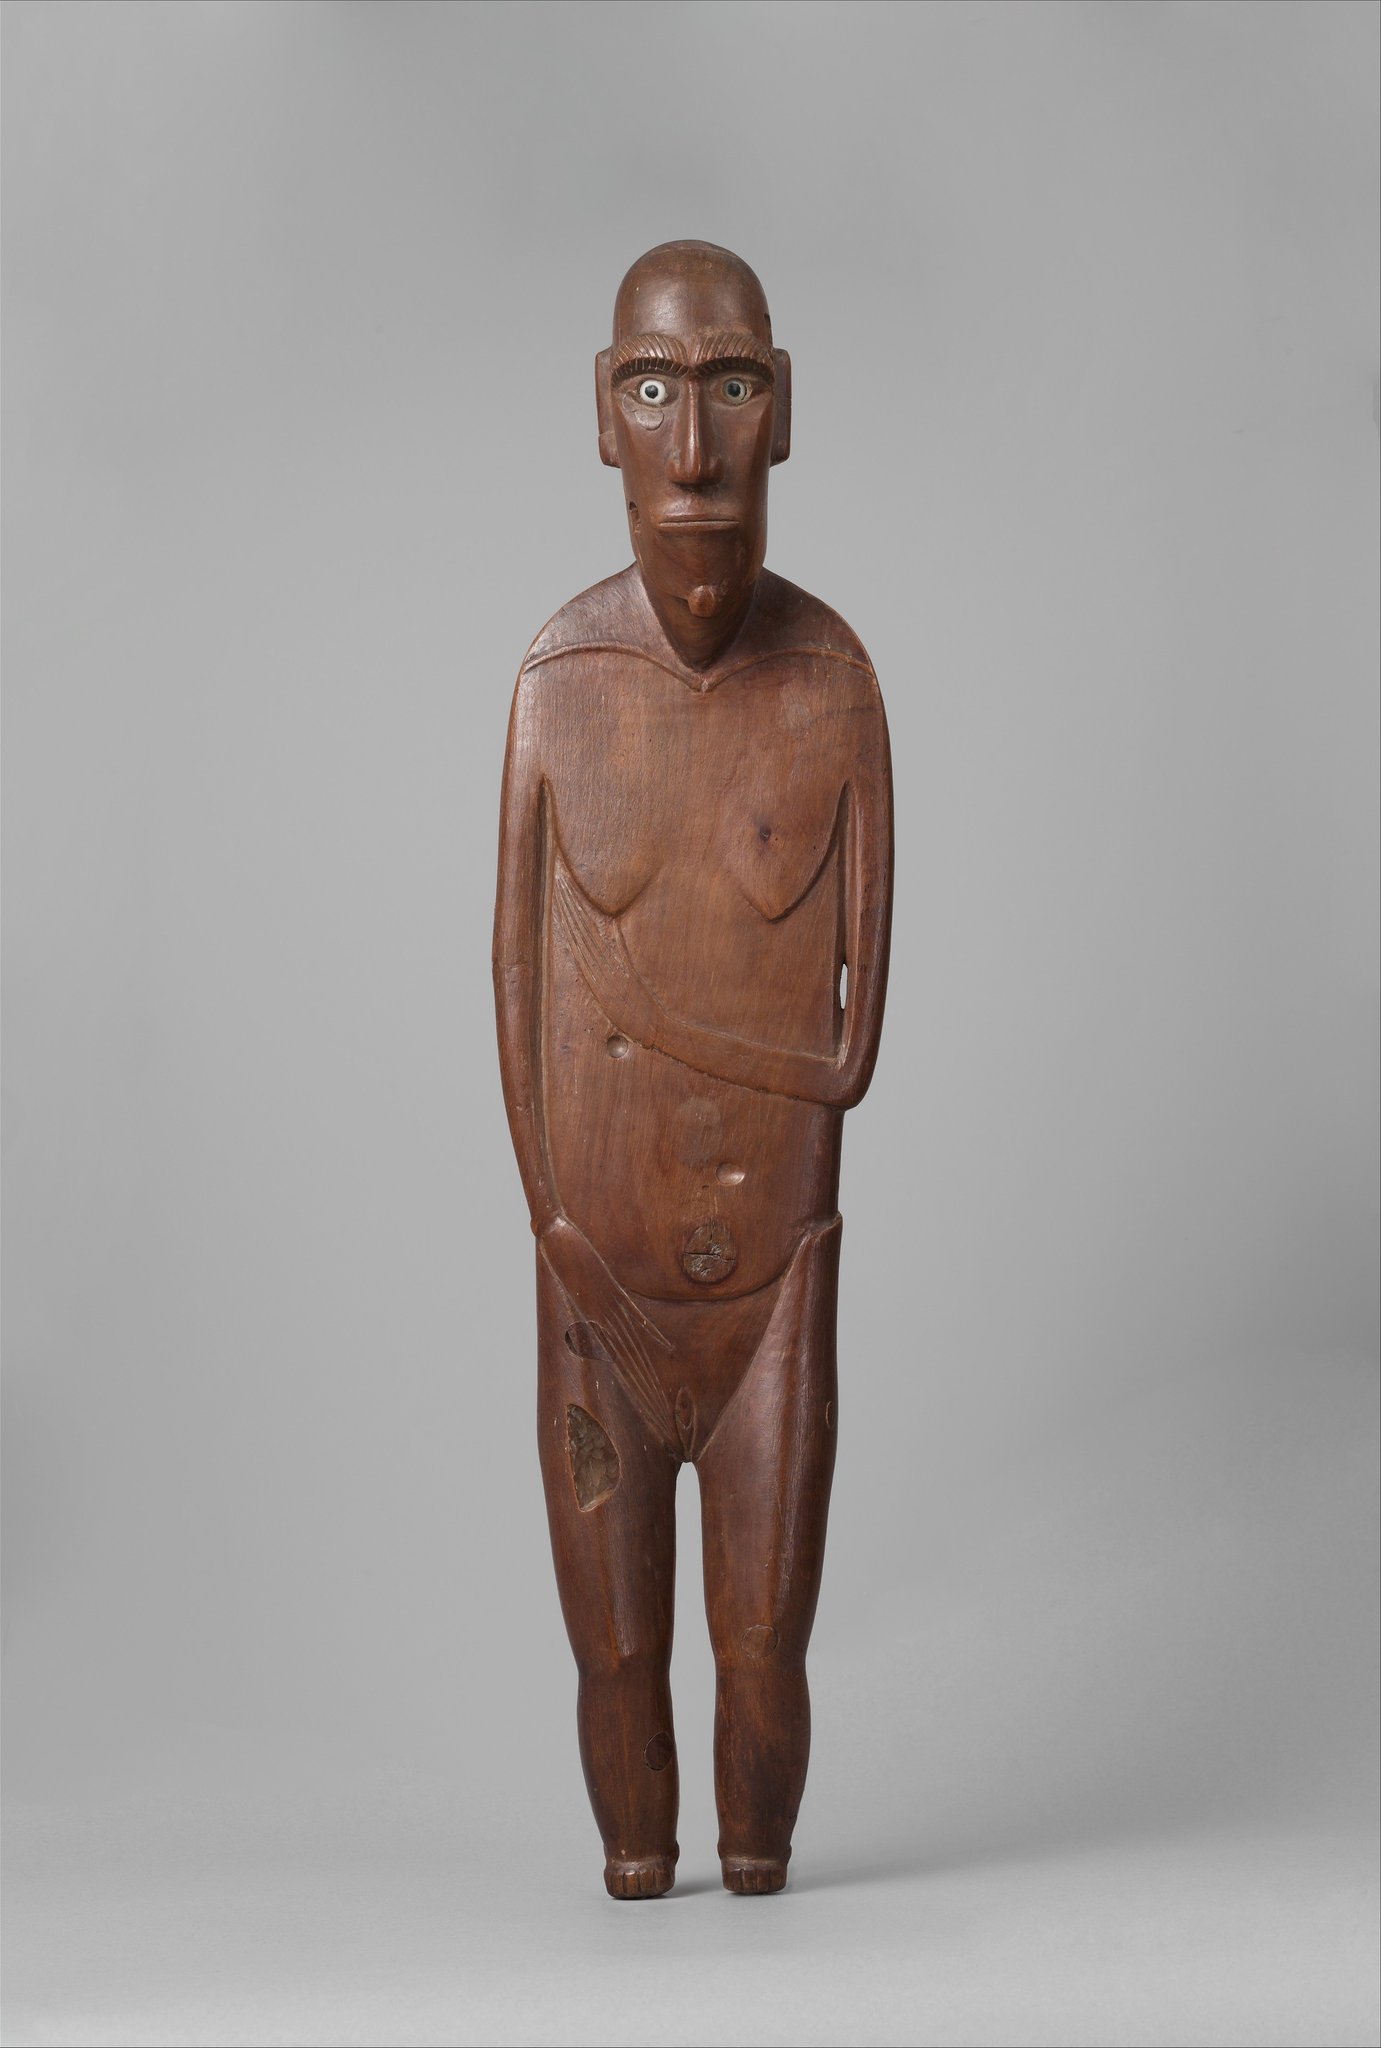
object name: figure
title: Female Figure (Moai Papa)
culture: rapa nui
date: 1801-1900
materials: glass, paint, wood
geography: chile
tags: women